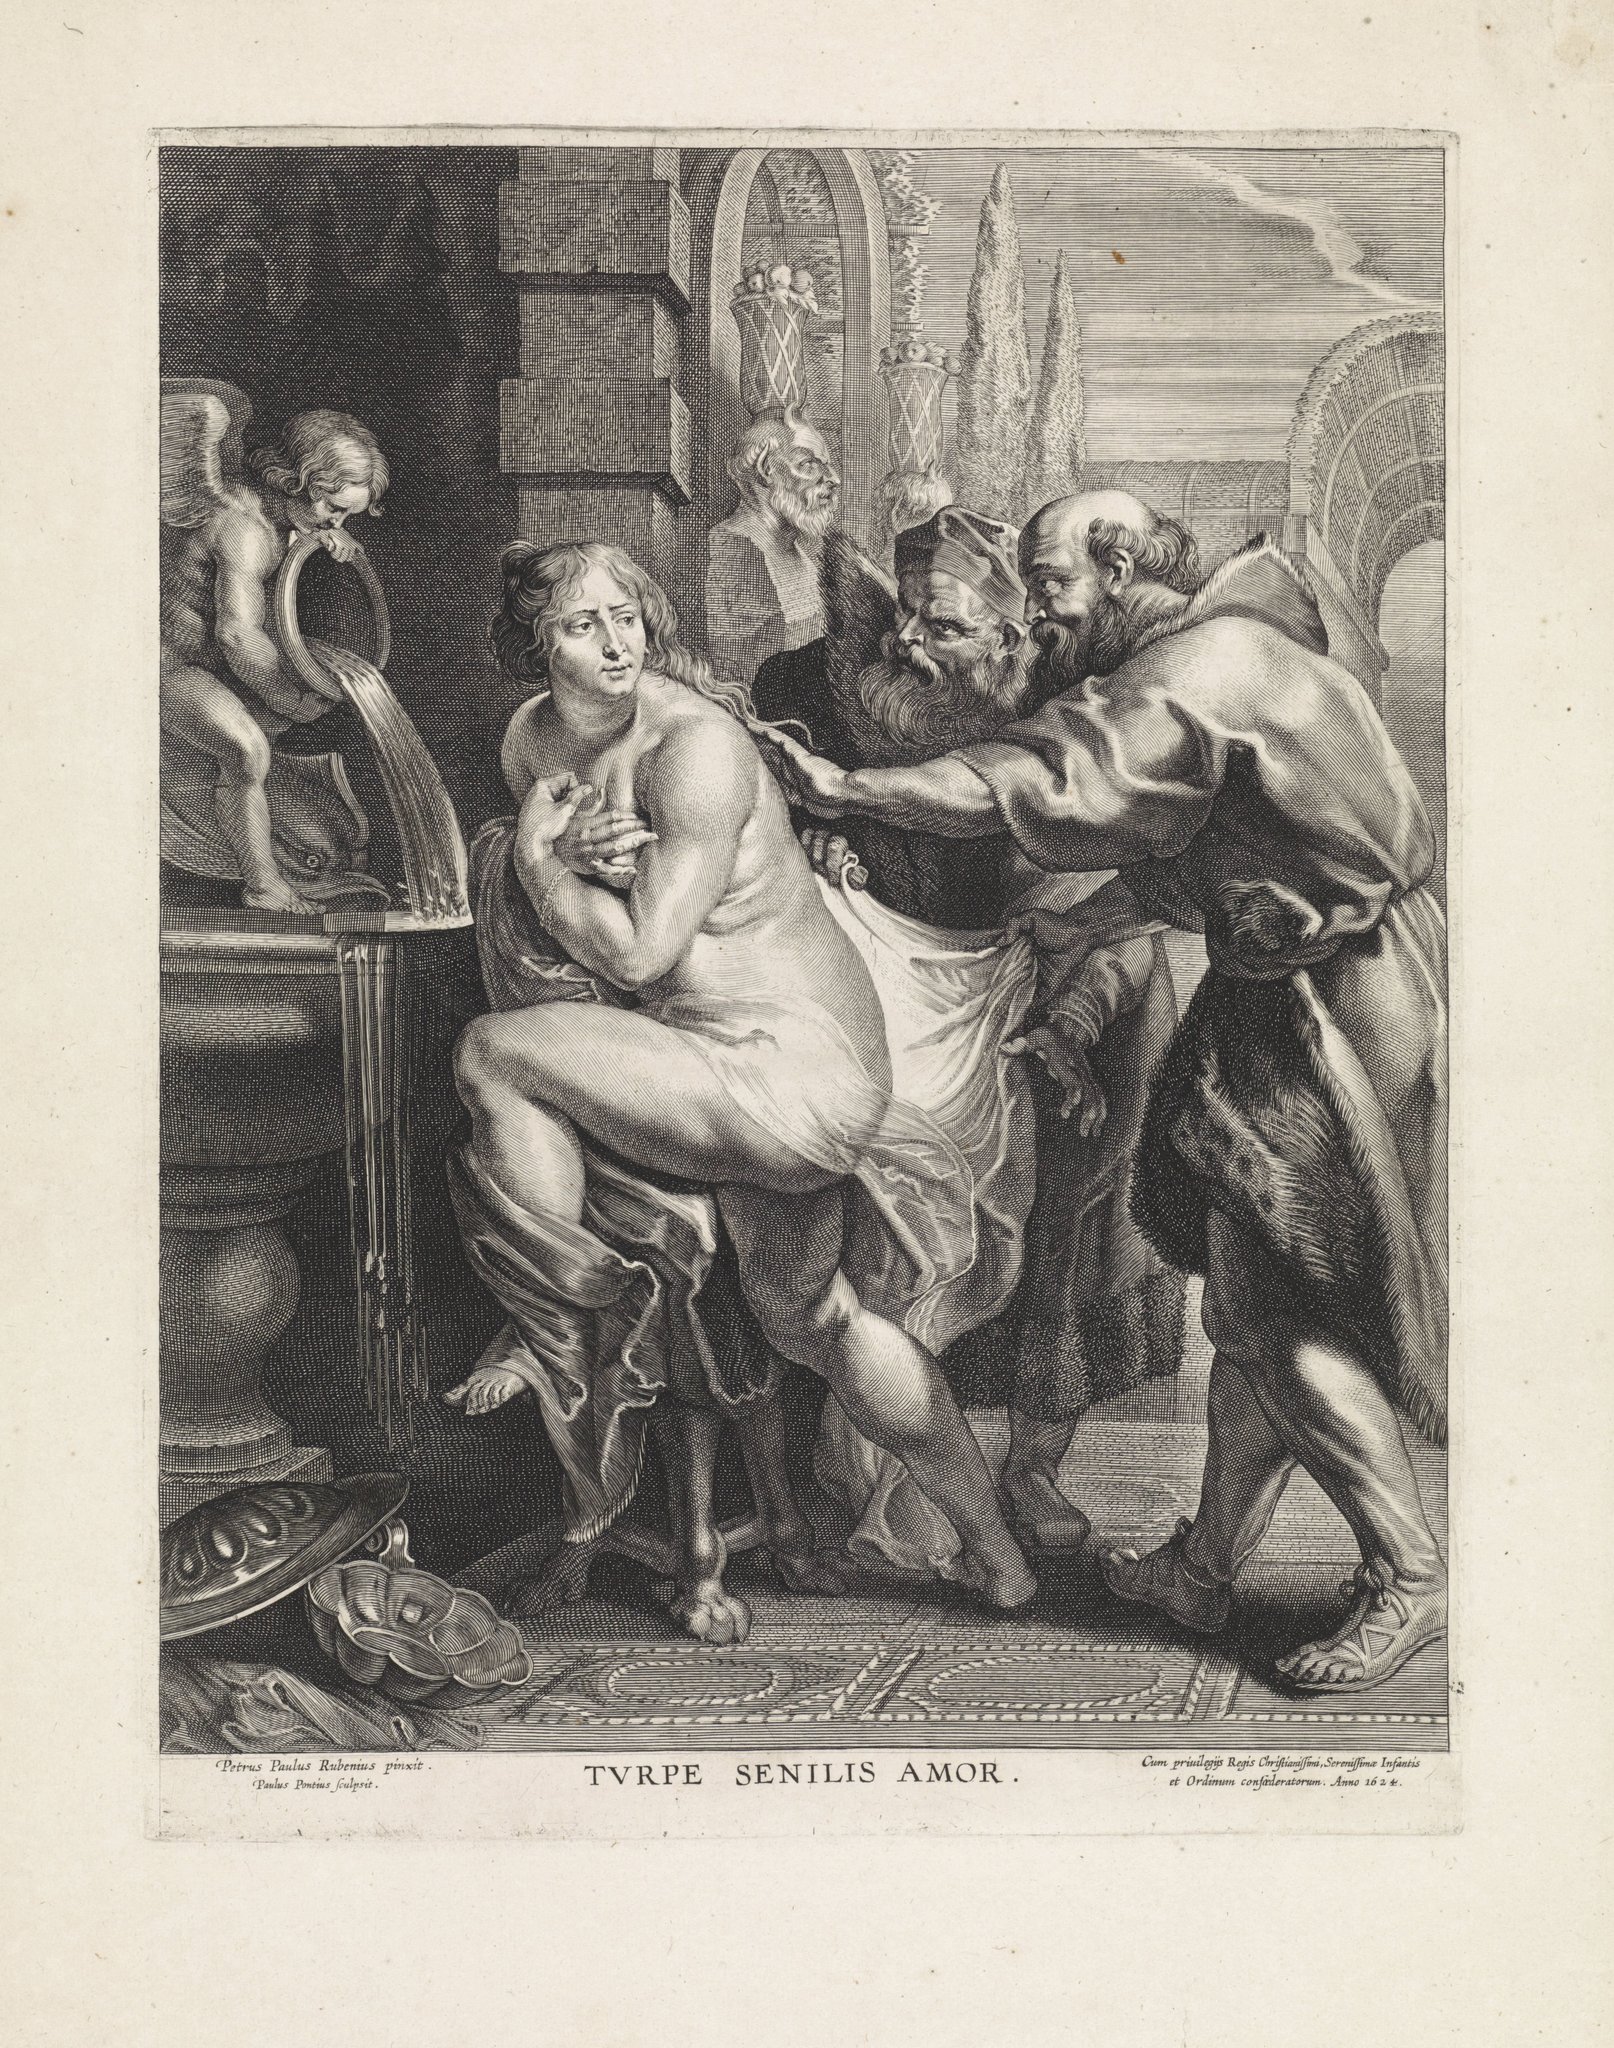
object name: print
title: Susanna en de ouderlingen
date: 1624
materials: paper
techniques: engraving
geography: antwerp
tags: the elders making advances towards susanna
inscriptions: collector's mark: Lugt 240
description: Susanna wordt bij het baden door twee ouderlingen betast. Ze probeert haar lichaam te bedekken.